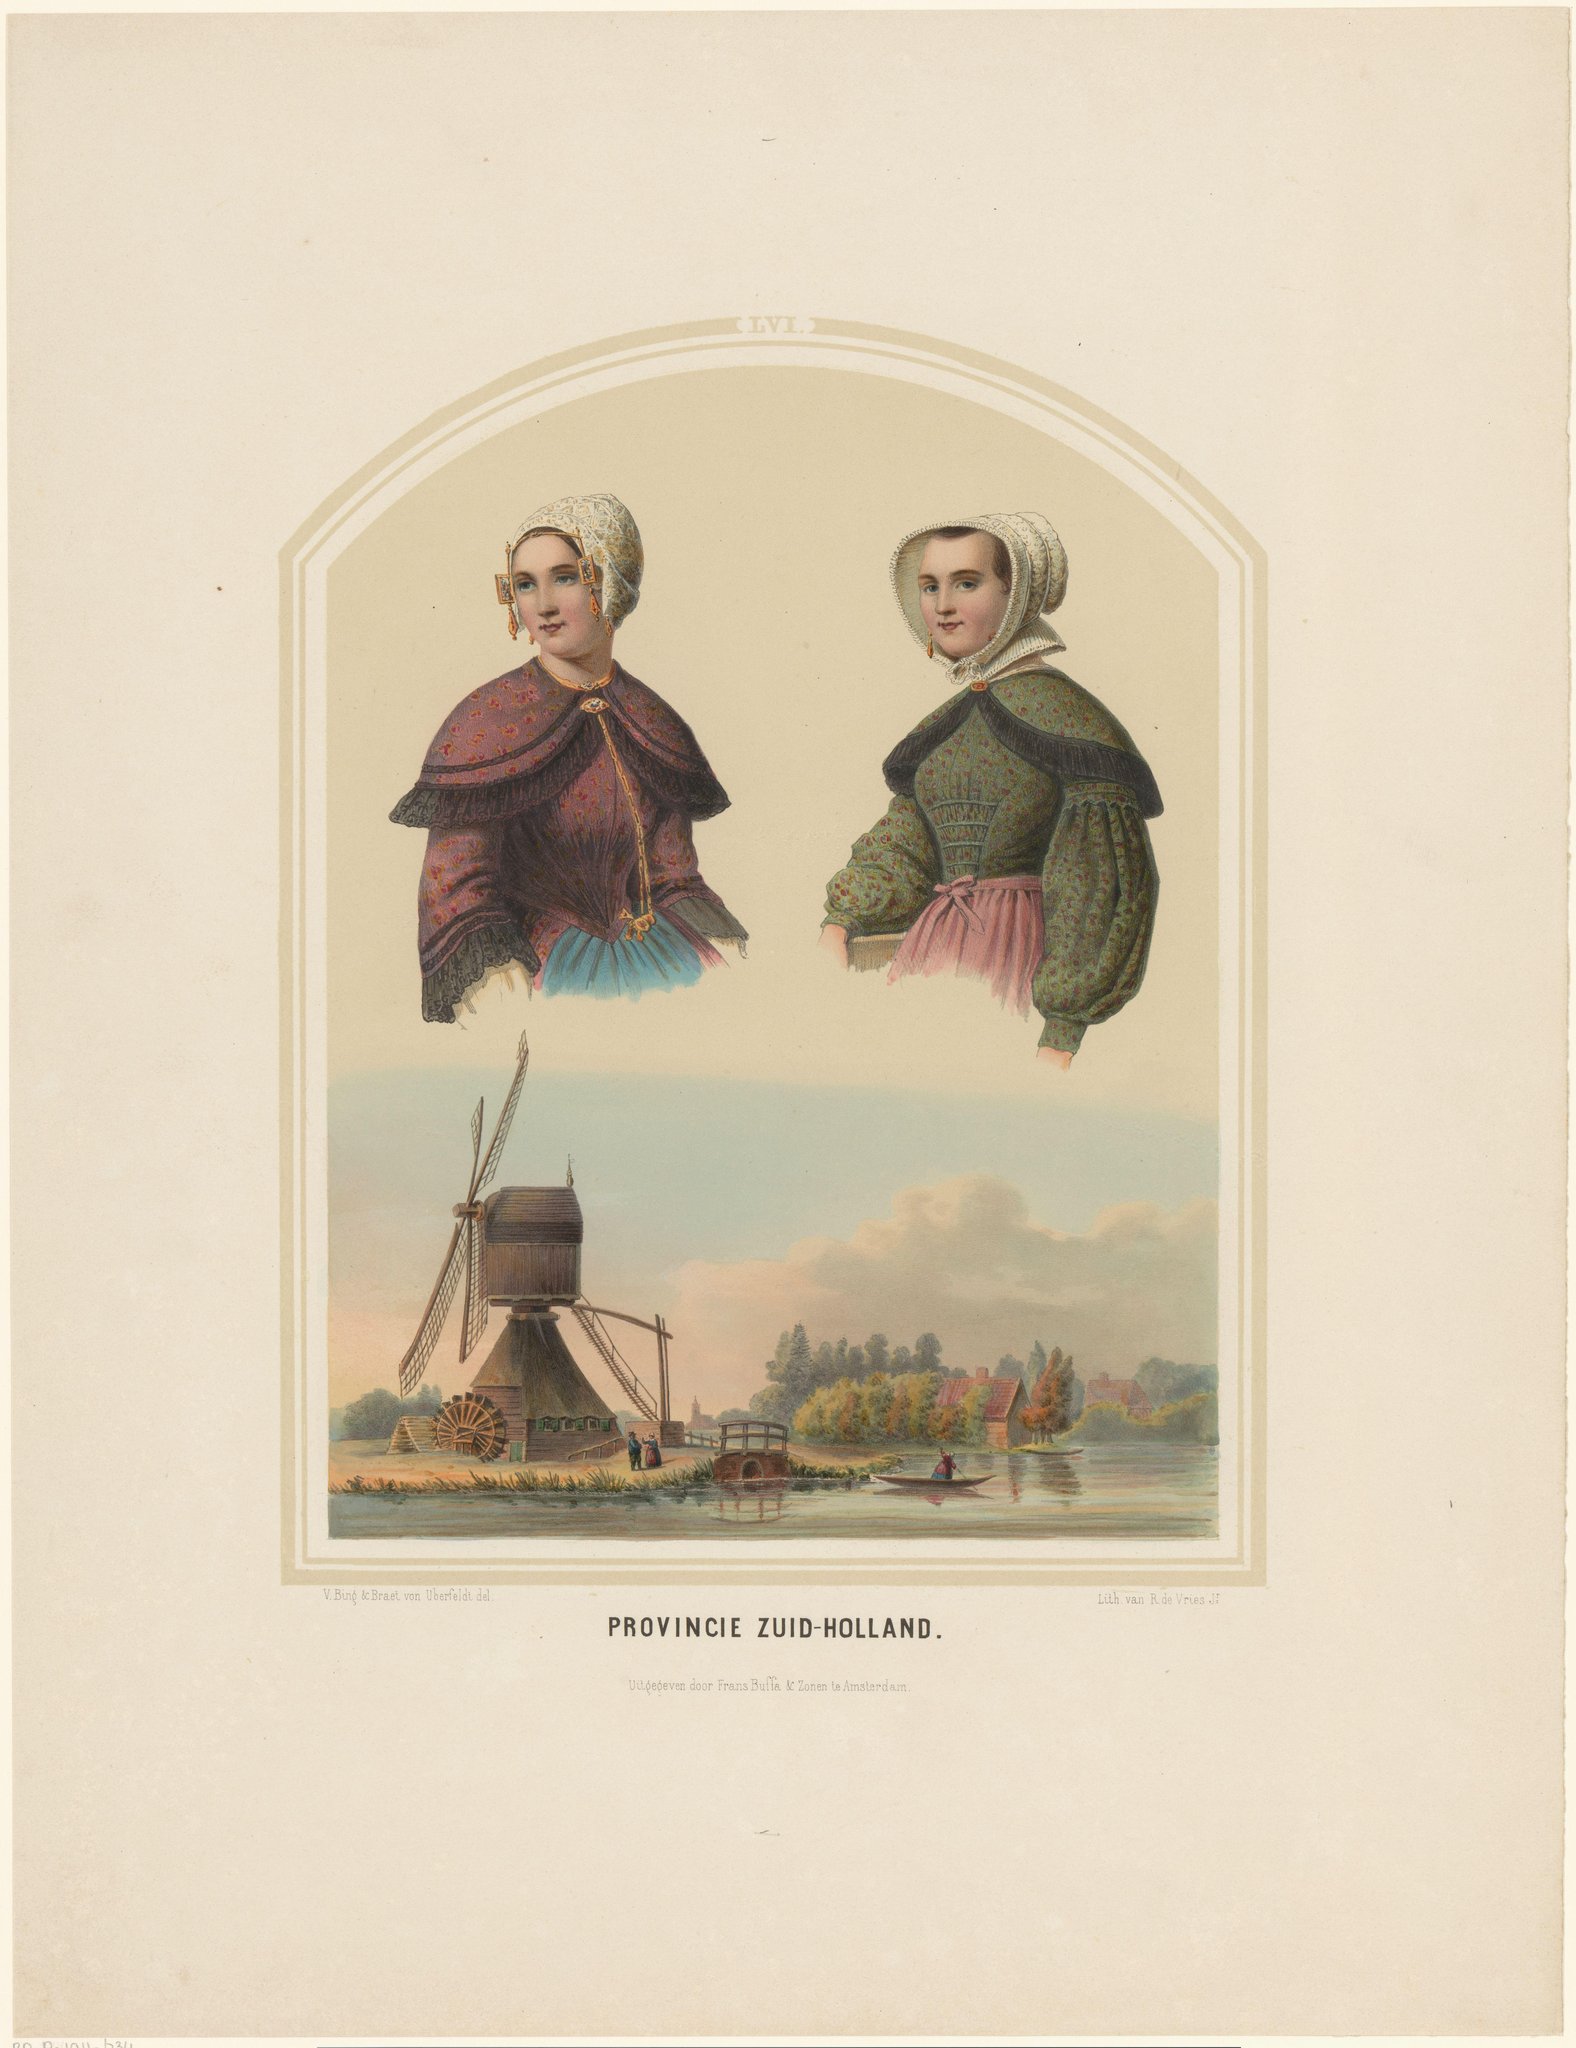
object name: costume print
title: Provincie Zuid-Holland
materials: paper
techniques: hand coloring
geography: amsterdam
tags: folk costume, regional costume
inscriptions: collector's mark: Lugt 2228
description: Klederdracht van de provincie Zuid-Holland. Aan de bovenzijde twee vrouwen, daaronder een landschap met molen.